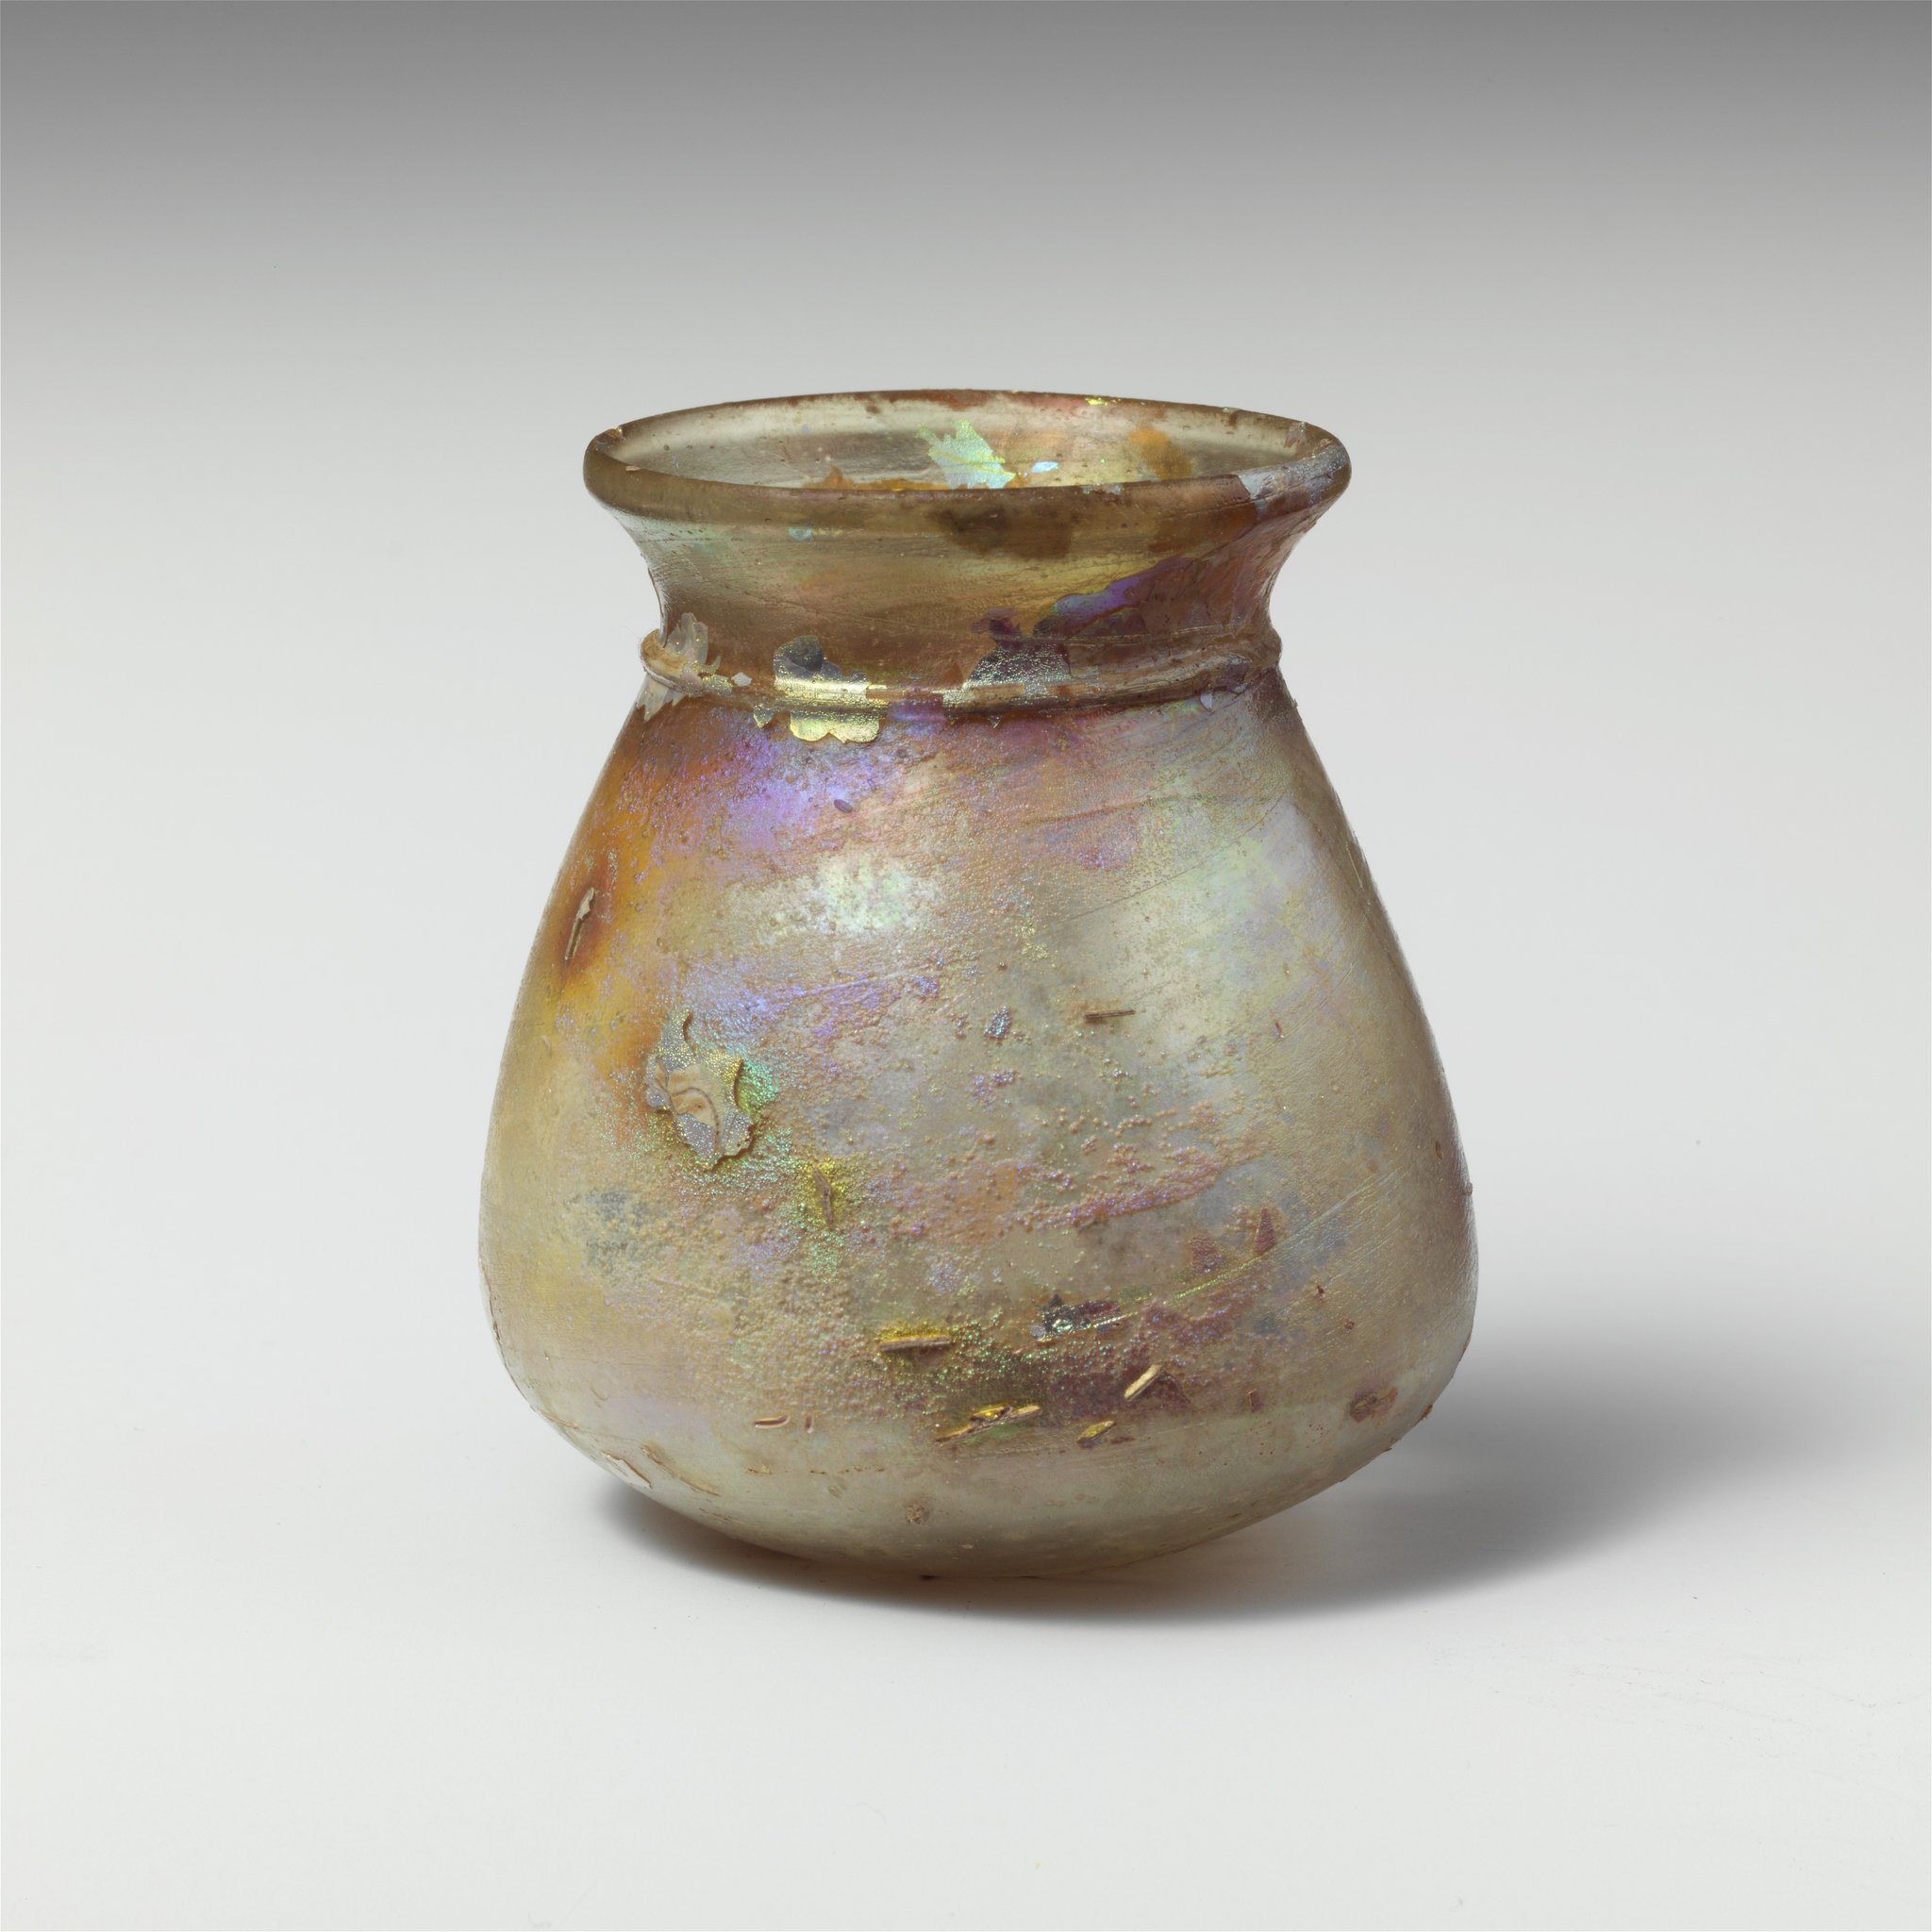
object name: jar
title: Glass jar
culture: roman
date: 201-300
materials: glass